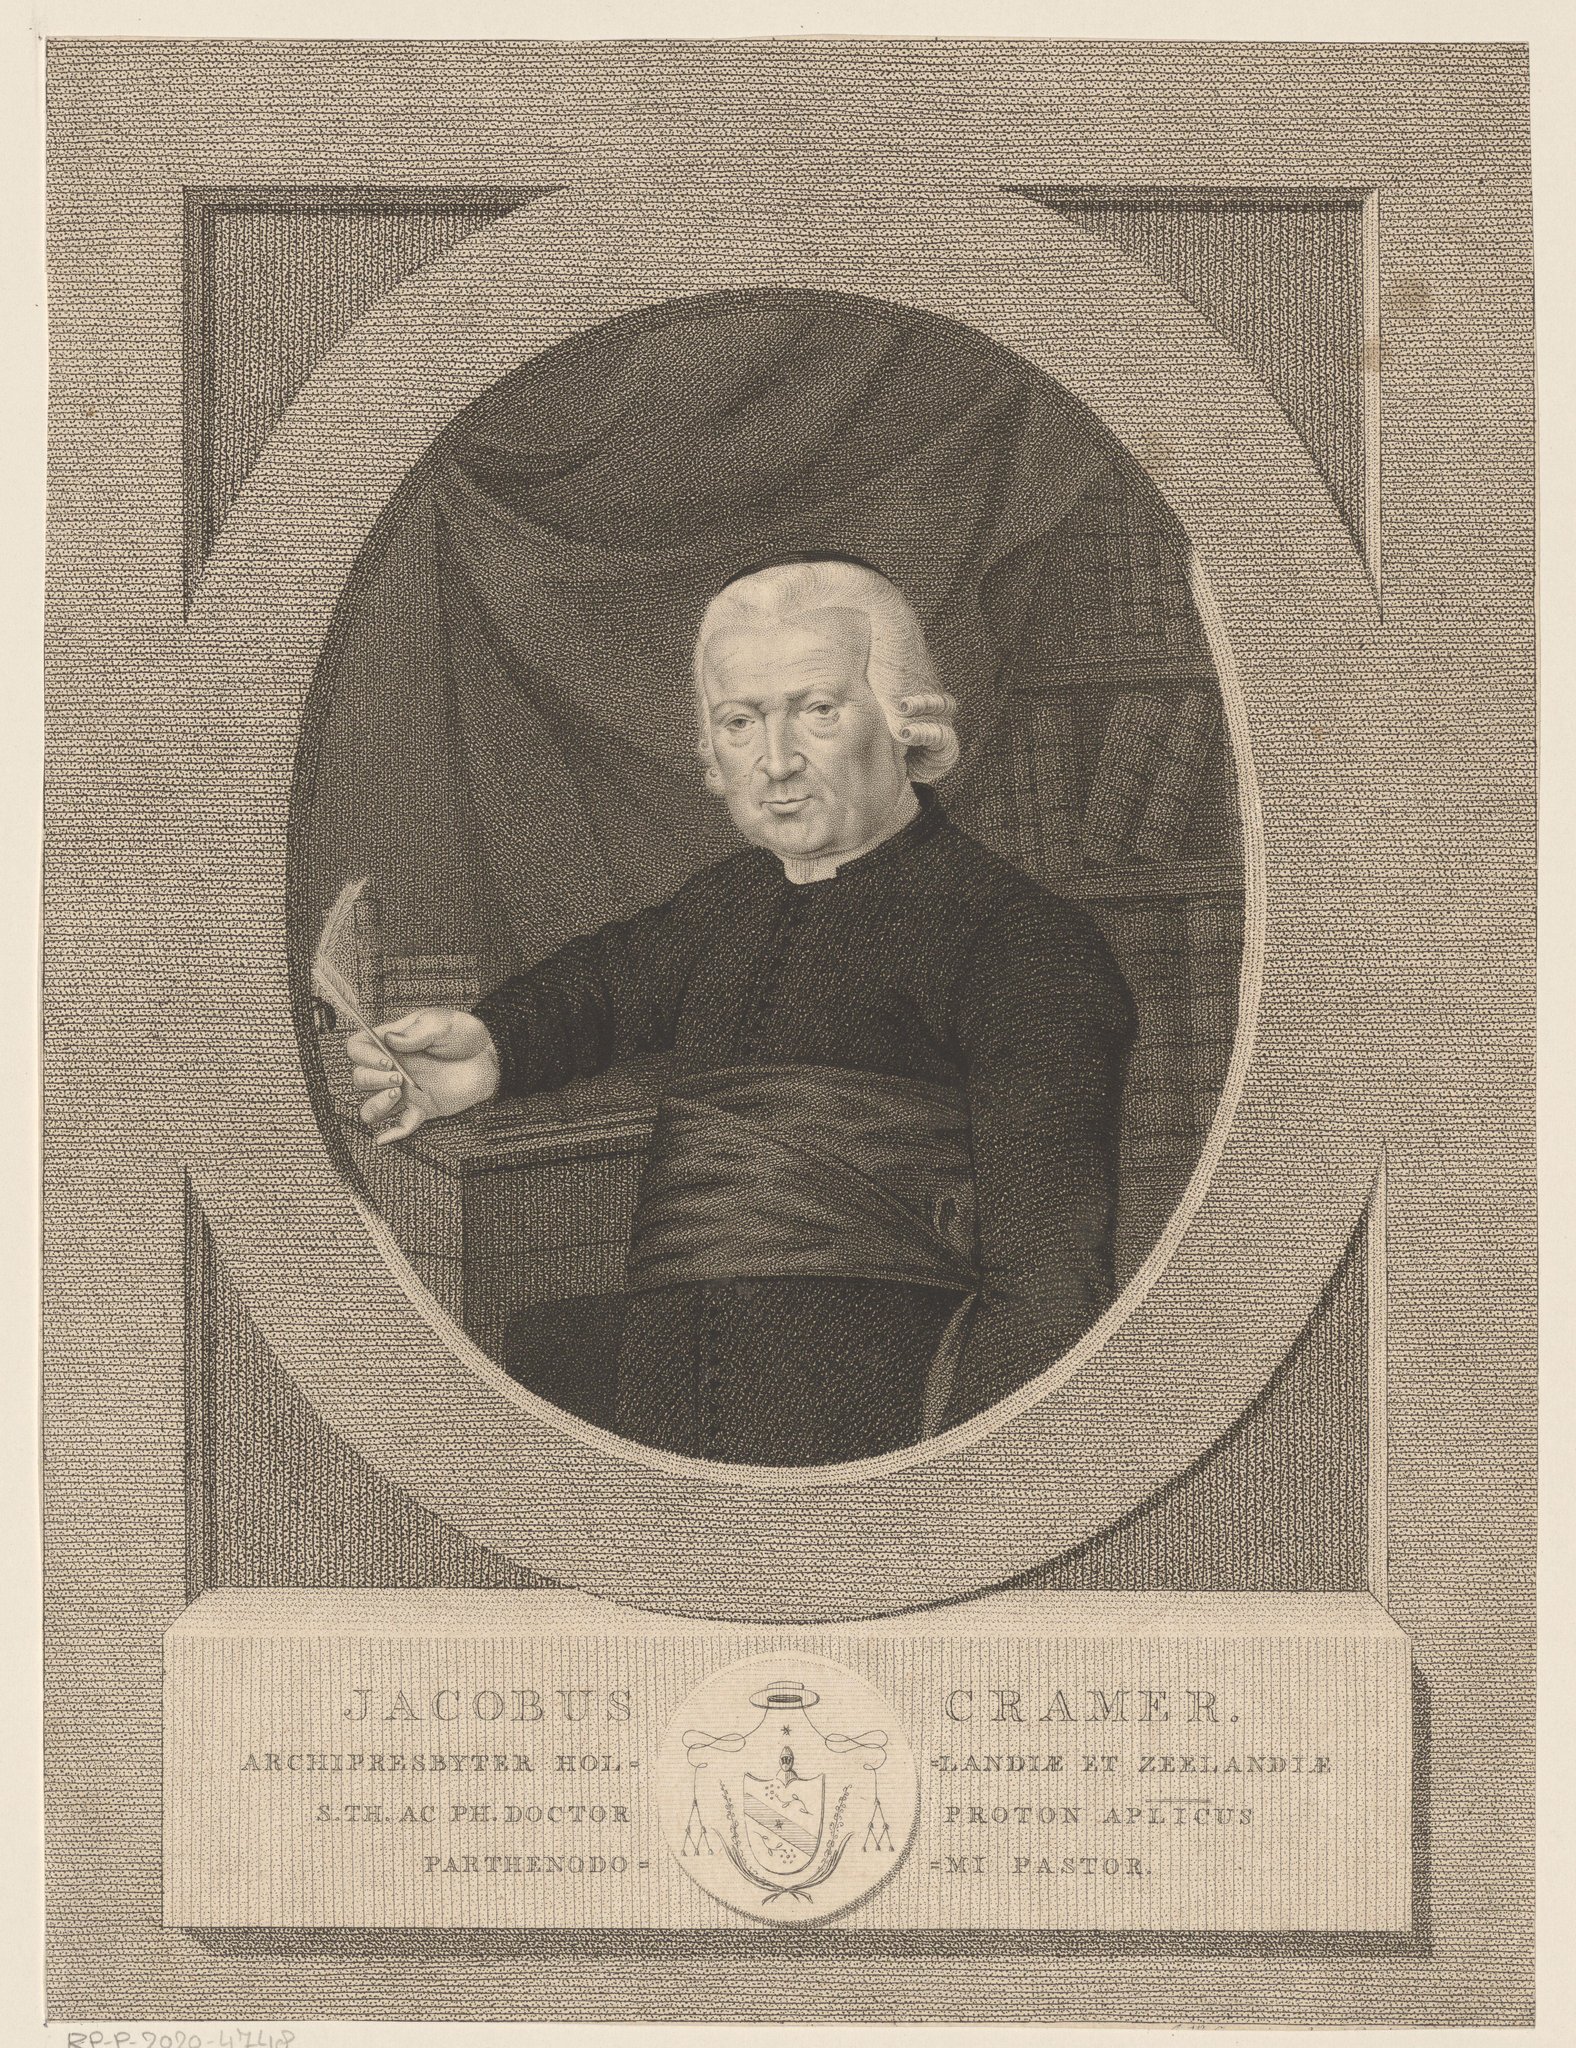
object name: print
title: Portret van Jacobus Cramer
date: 1789-1822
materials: paper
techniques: etching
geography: amsterdam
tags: priest, historical persons